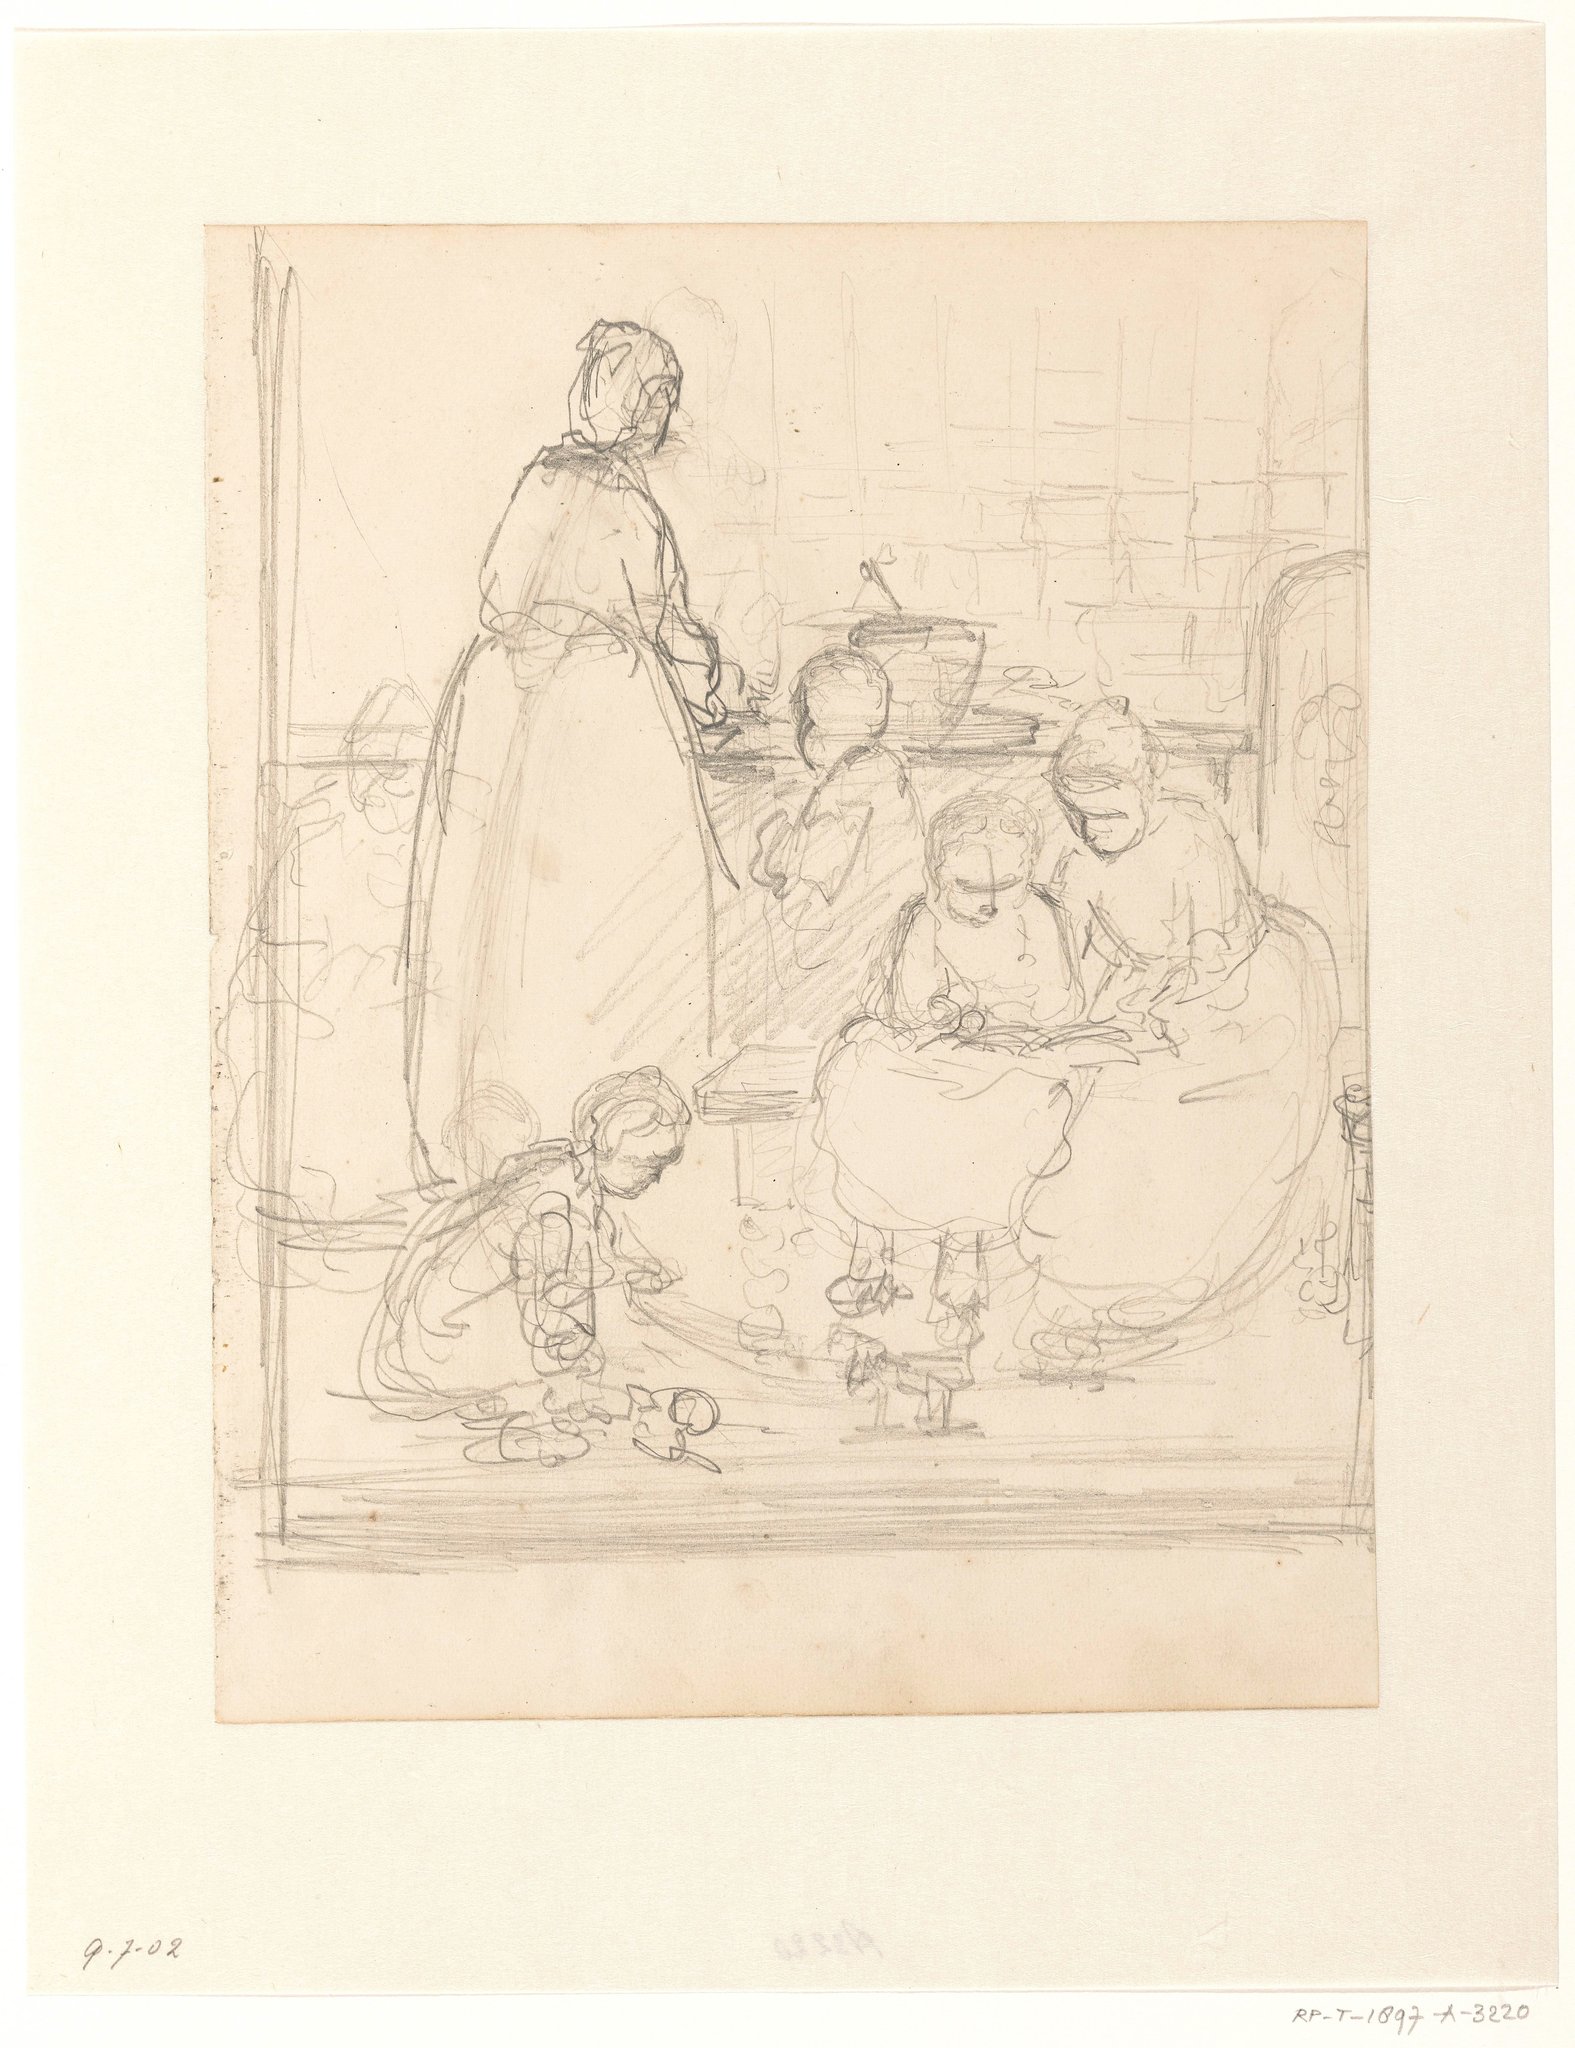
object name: drawing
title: Interieur met keuken en spelende kinderen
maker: hendrik valkenburg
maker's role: draughtsman, painter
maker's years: 1826-1896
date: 1836-1896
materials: paper, pencil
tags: interior of the house, mother and child(ren), woman and child(ren) (family group)